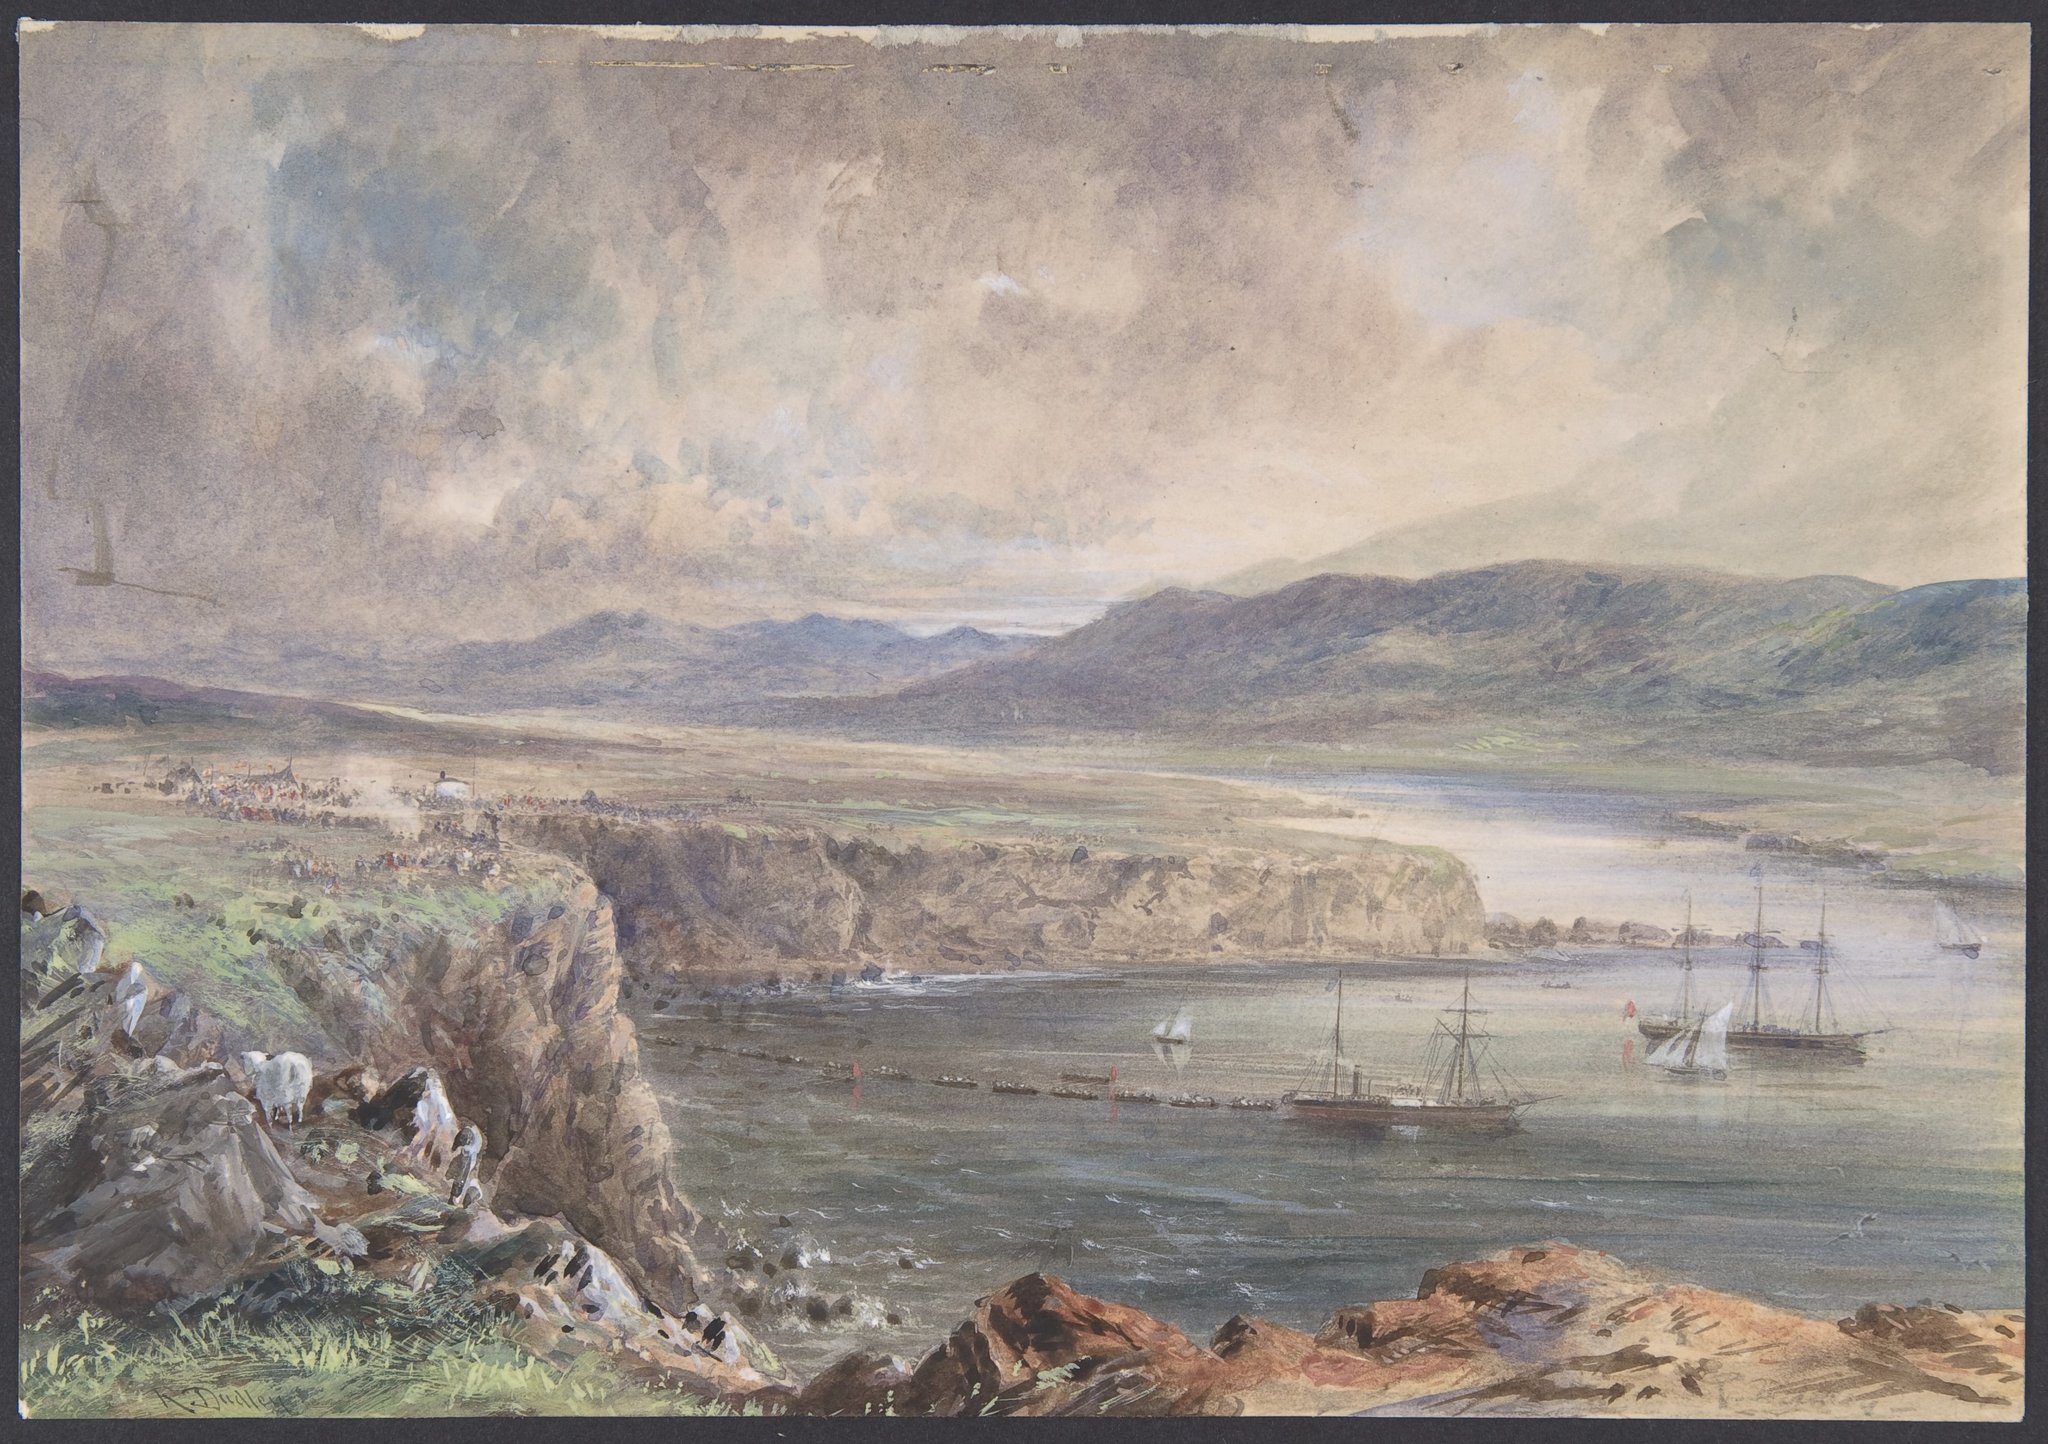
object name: drawing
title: Foilhummerum Bay, Valentia, Looking from Cromwell Fort: The Caroline and Boats Laying the Earth Wire, July 21st, 1865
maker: robert charles dudley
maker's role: artist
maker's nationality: british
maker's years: 1826-1909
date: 1865-1866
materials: gouache, graphite, watercolor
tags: landscapes,ships,transatlantic cable